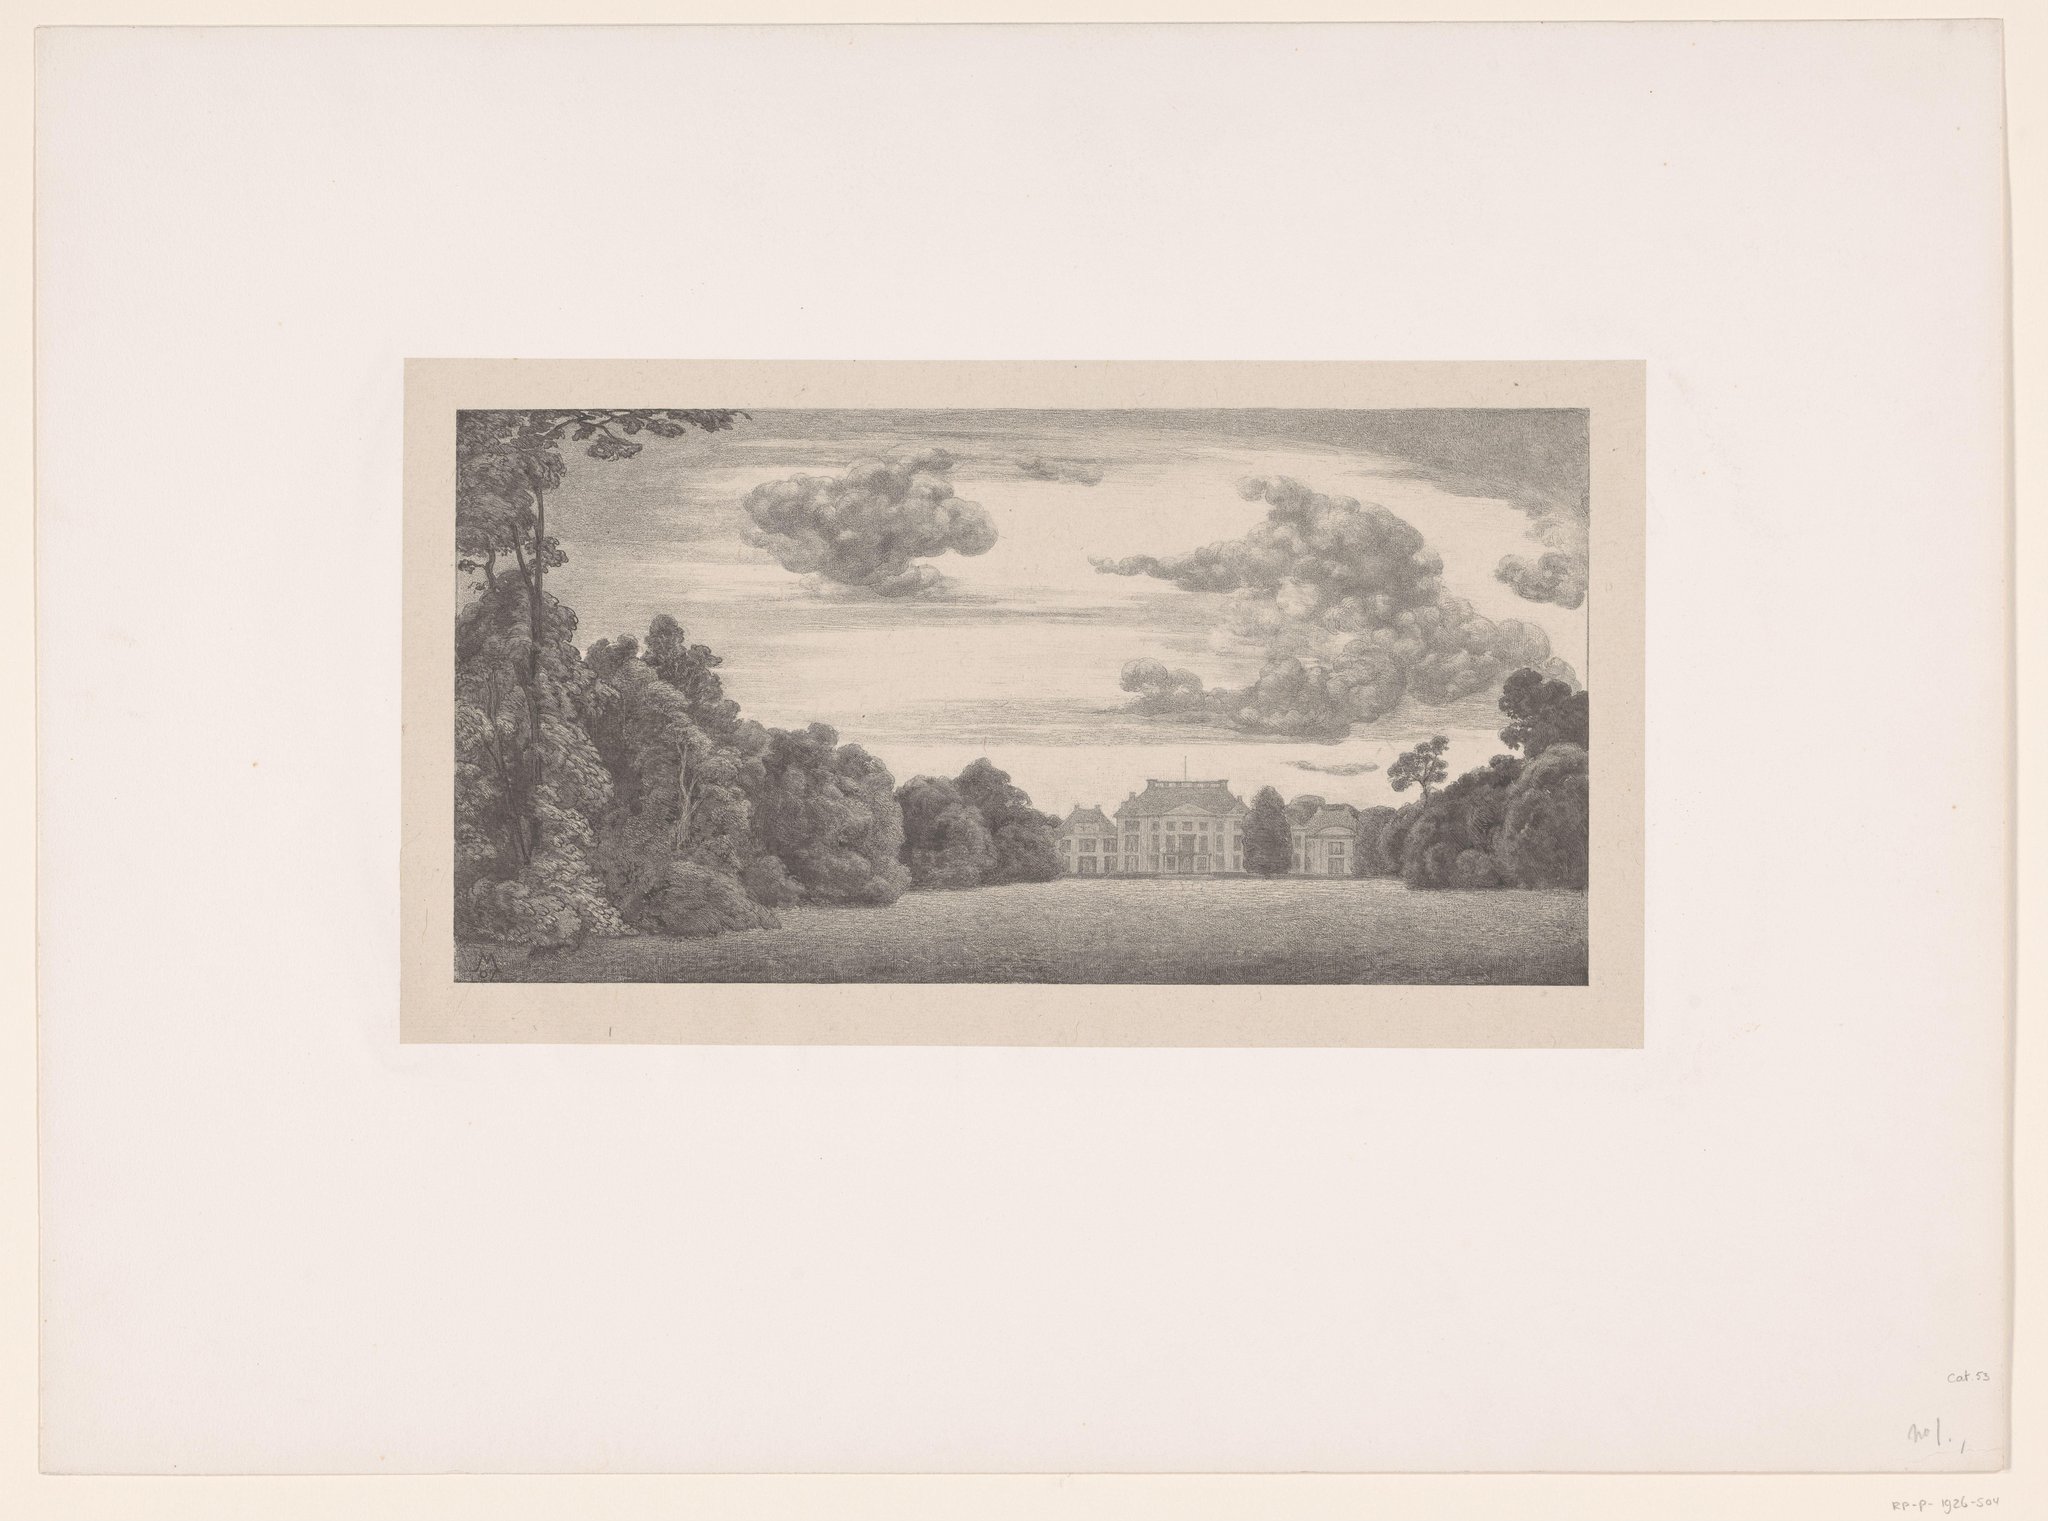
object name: print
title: Gezicht op Paleis het Loo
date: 1907-1909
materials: paper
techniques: lithograph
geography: amsterdam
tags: palace